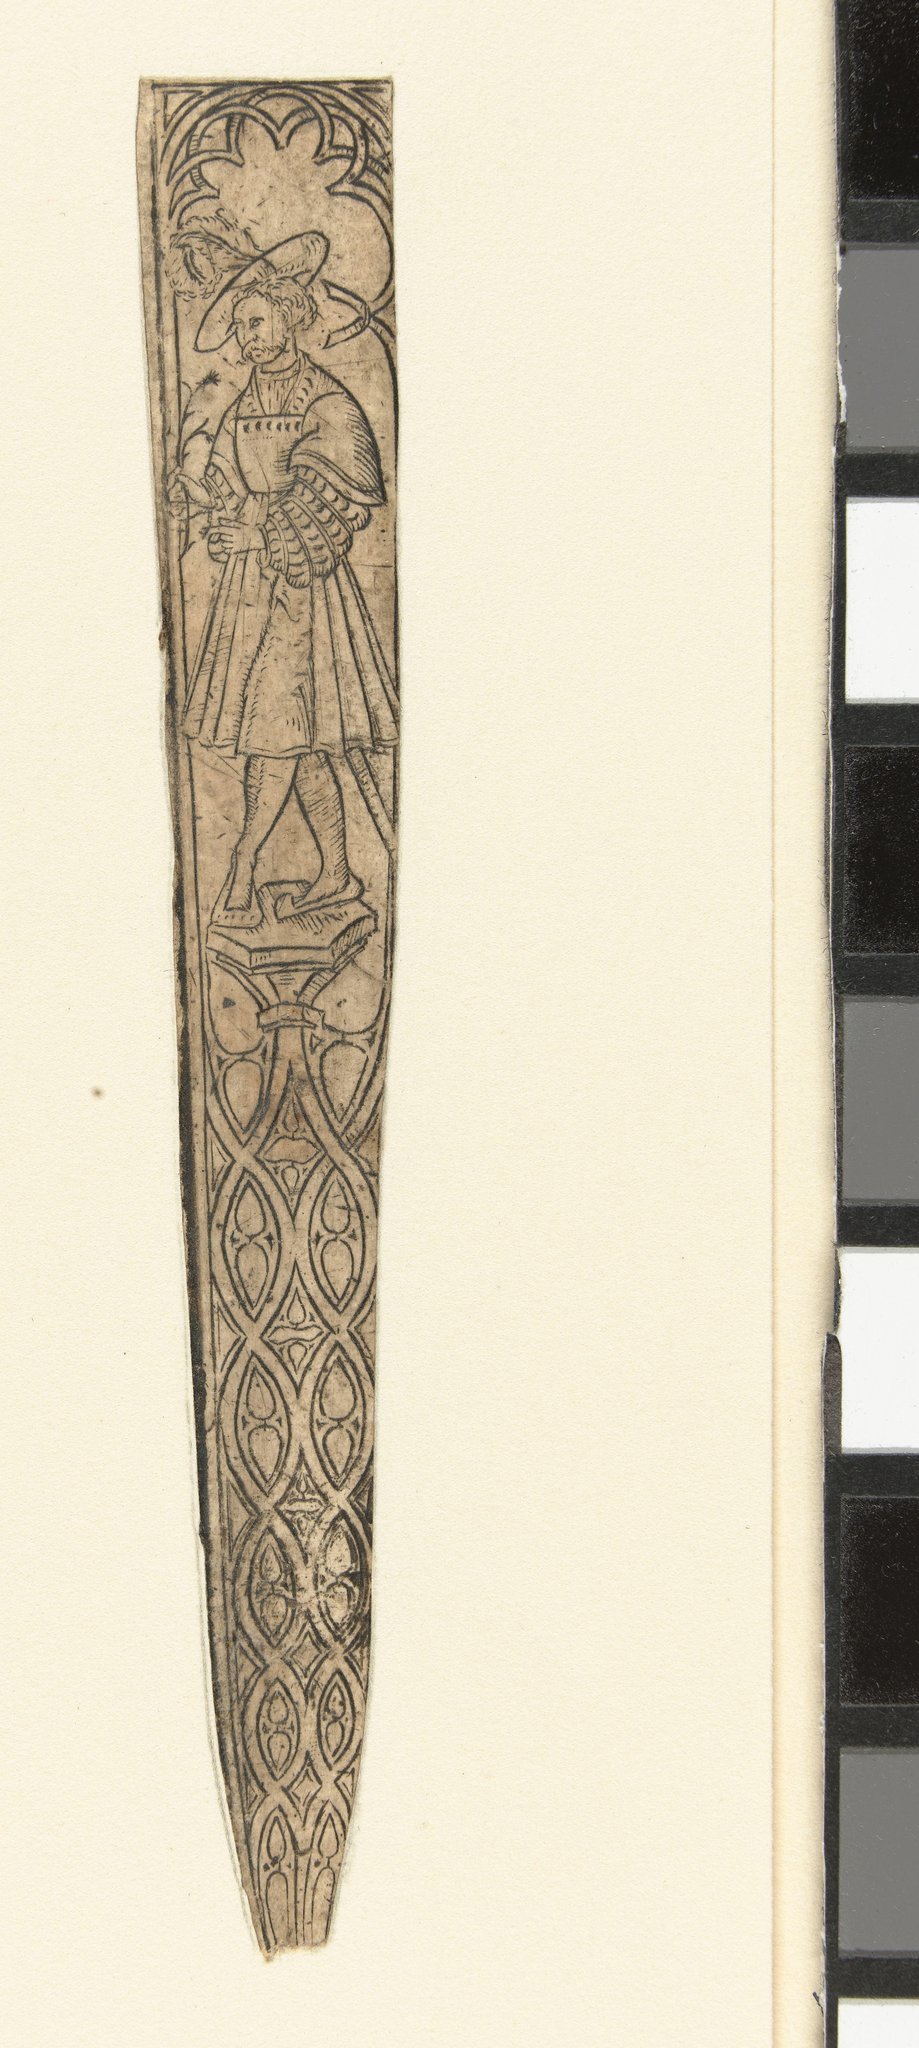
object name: ornament print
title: Schede met bovenaan een man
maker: Anonymous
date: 1500-1600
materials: paper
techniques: engraving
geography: germany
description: Bovenaan staat een man met een hoed op en een bloem in zijn hand onder een gotisch boogje. Het onderste gedeelte is gedecoreerd met geometrische motieven.